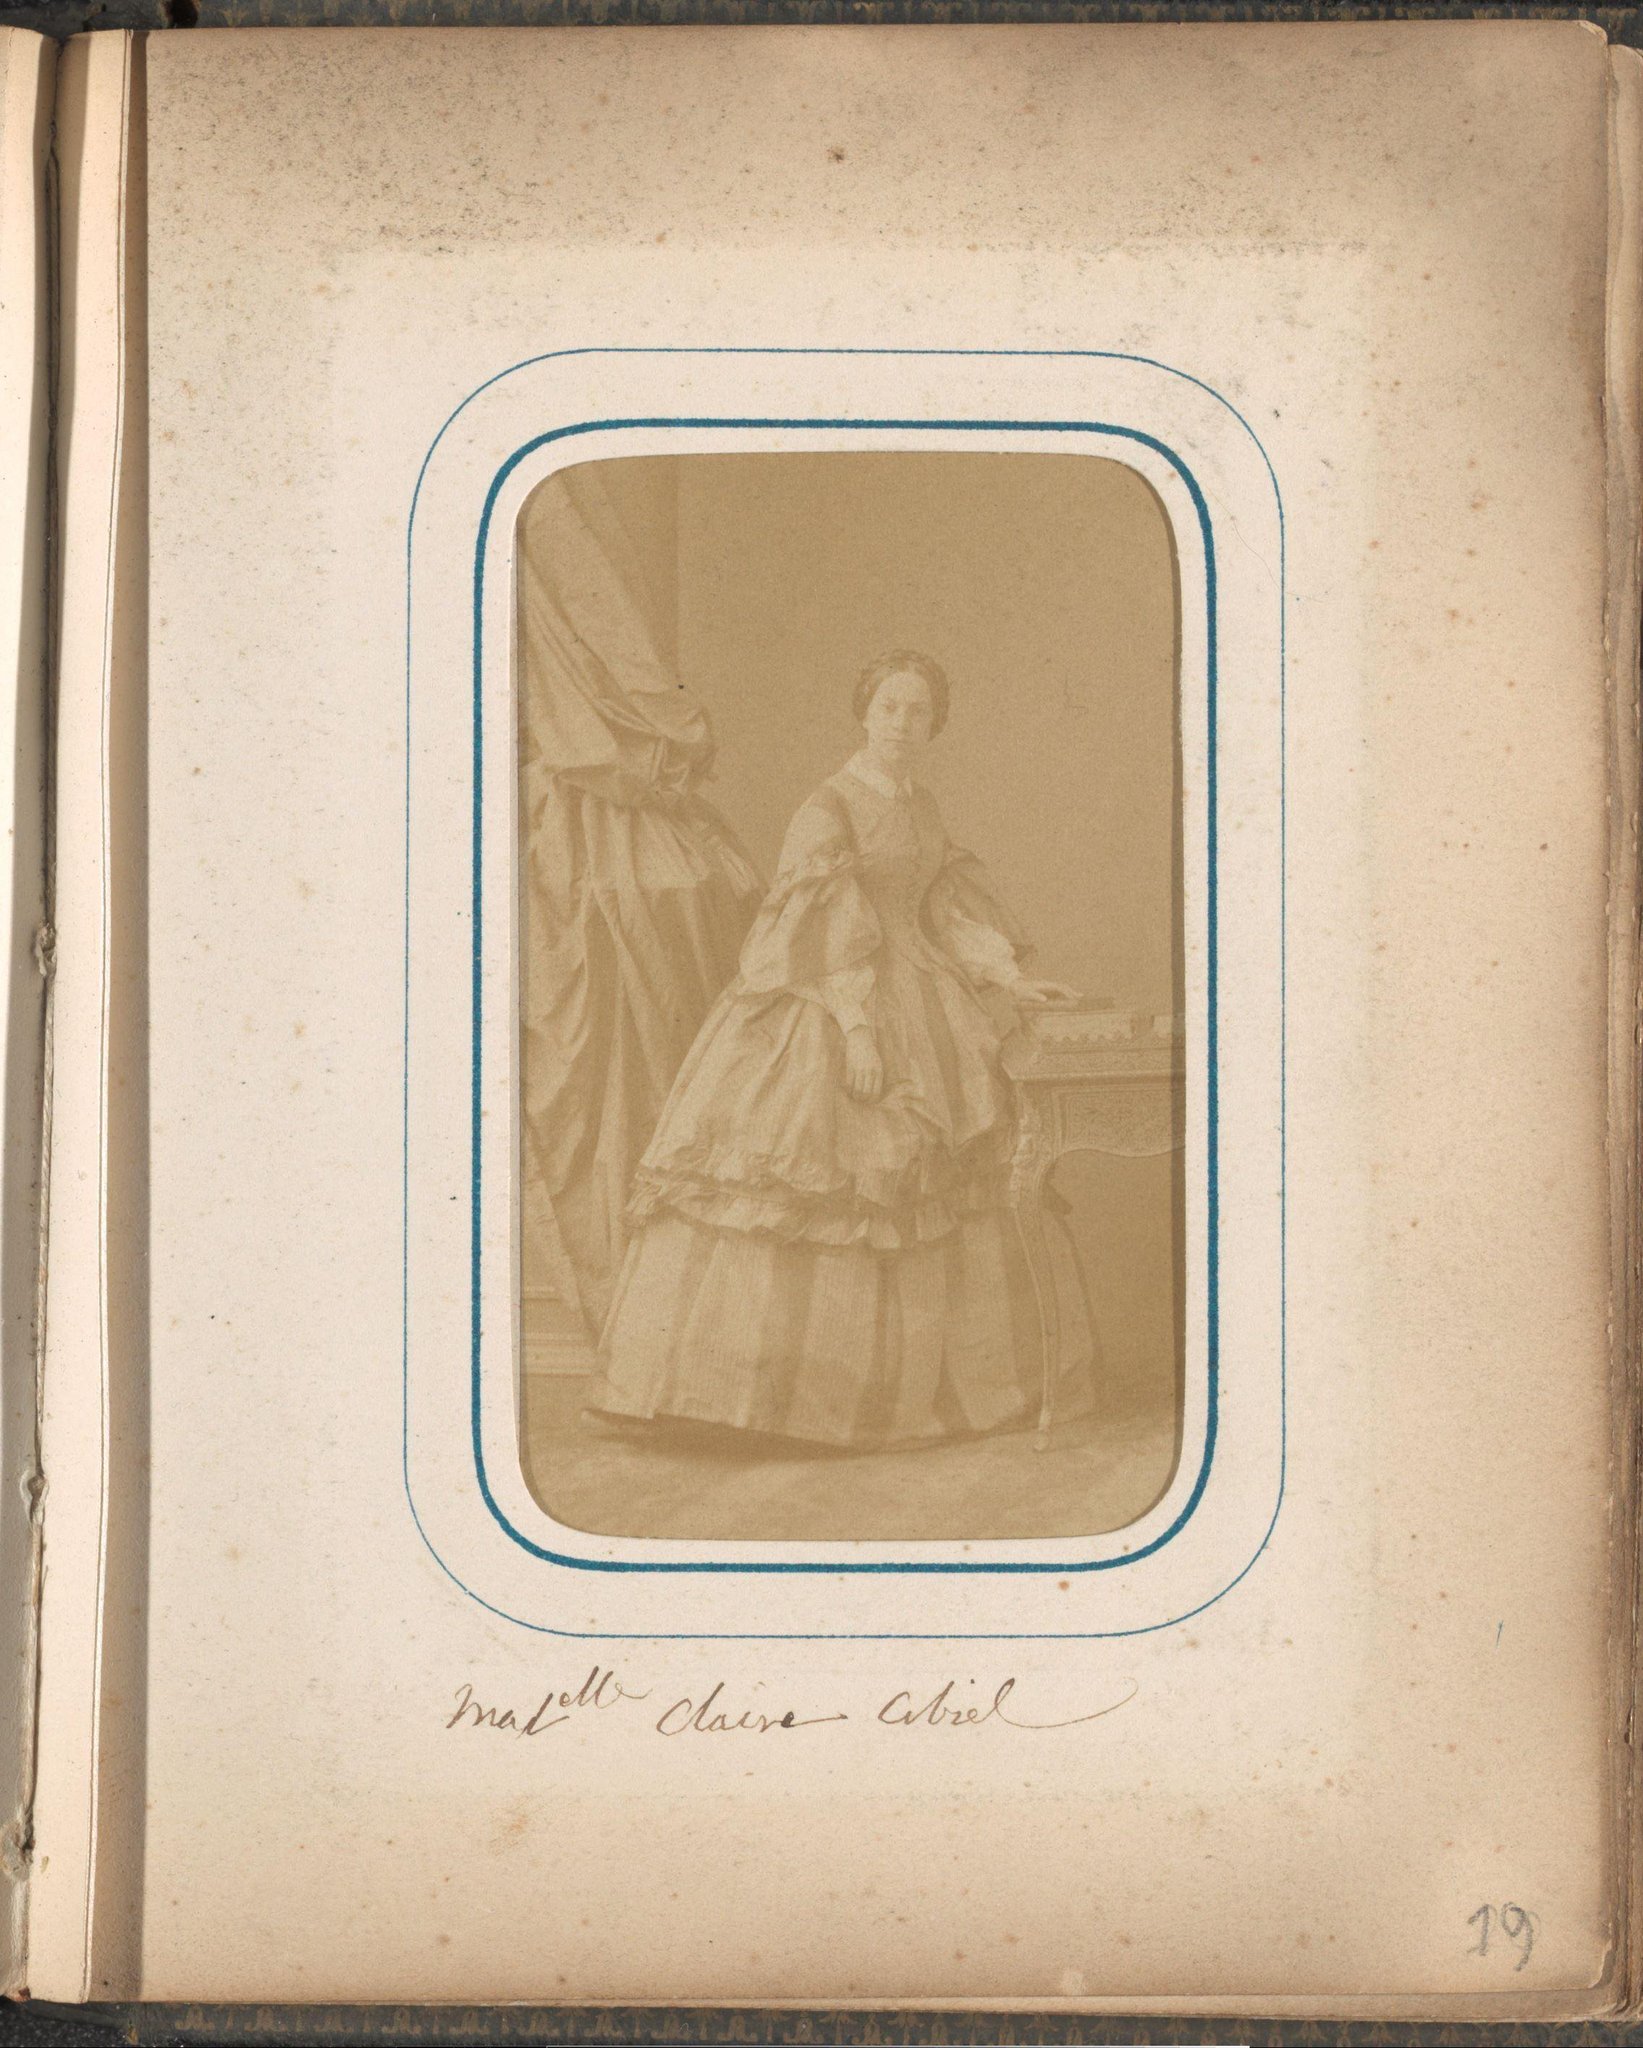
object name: carte de visite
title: Portret van Claire Cibiel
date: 1860-1865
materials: cardboard, paper, photographic support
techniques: albumen print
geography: paris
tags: studio requisites ~ photographer, historical persons, styles of hairdress - aa - ~ women, dress, gown, paris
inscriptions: name: ‘Mad. Claire Cibiel’, name: ‘Mad. Claire Cibiel’, address: ‘8, Boulevart des Italiens, Paris’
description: Onderdeel van Fotoalbum met 24 cartes-de-visite van Franse personen.